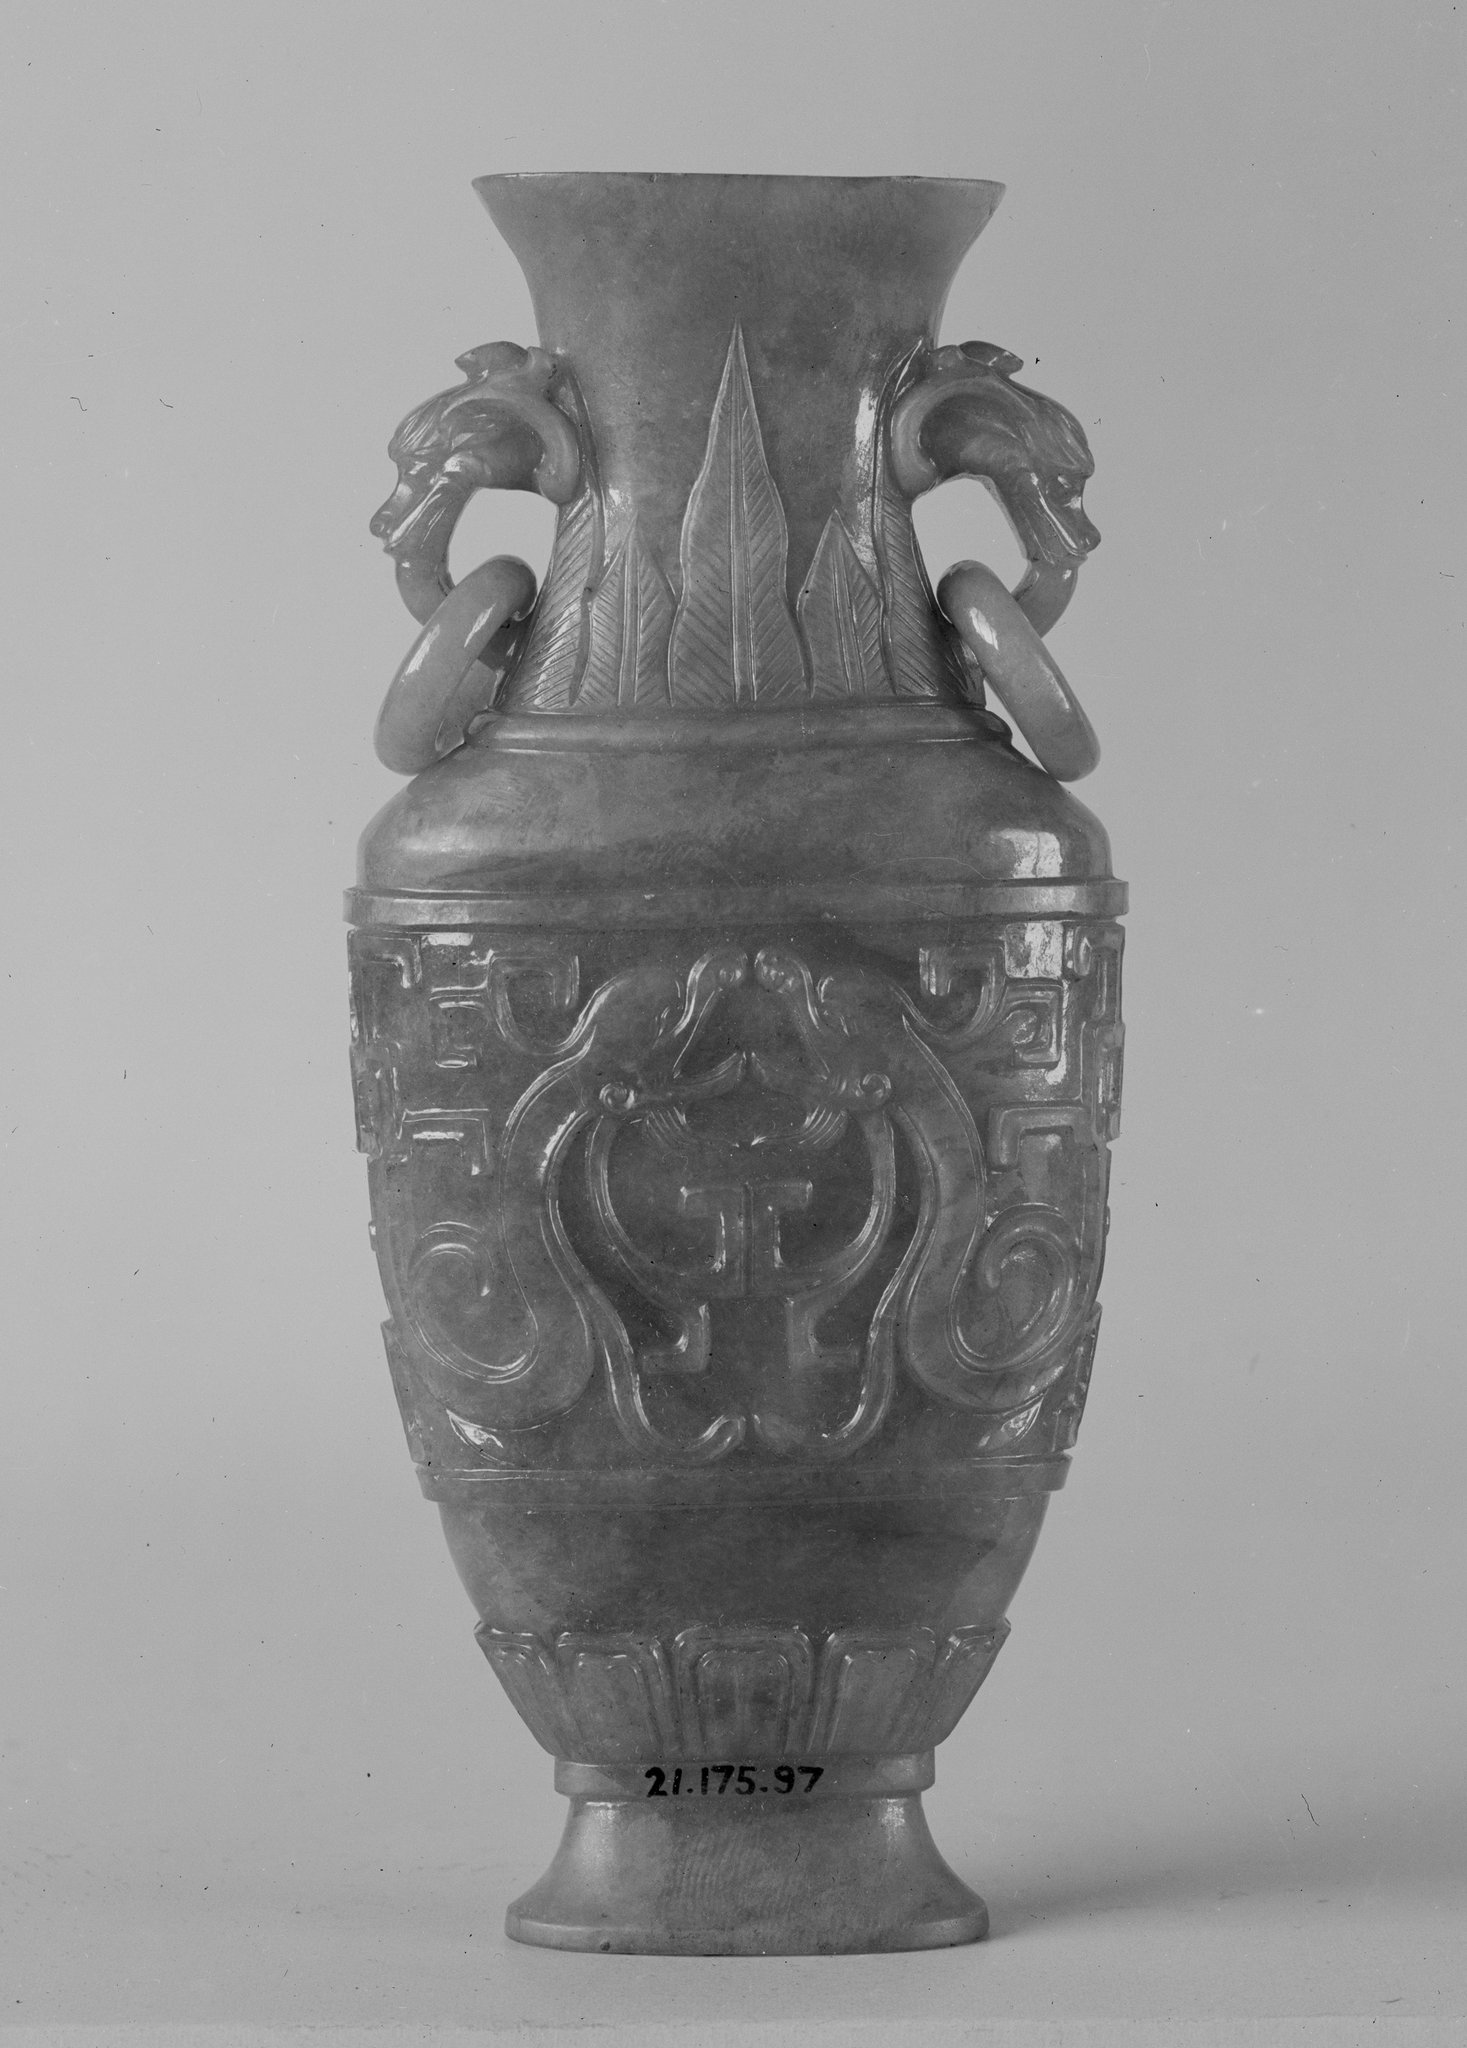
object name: vase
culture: chinese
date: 1736-1795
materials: jade